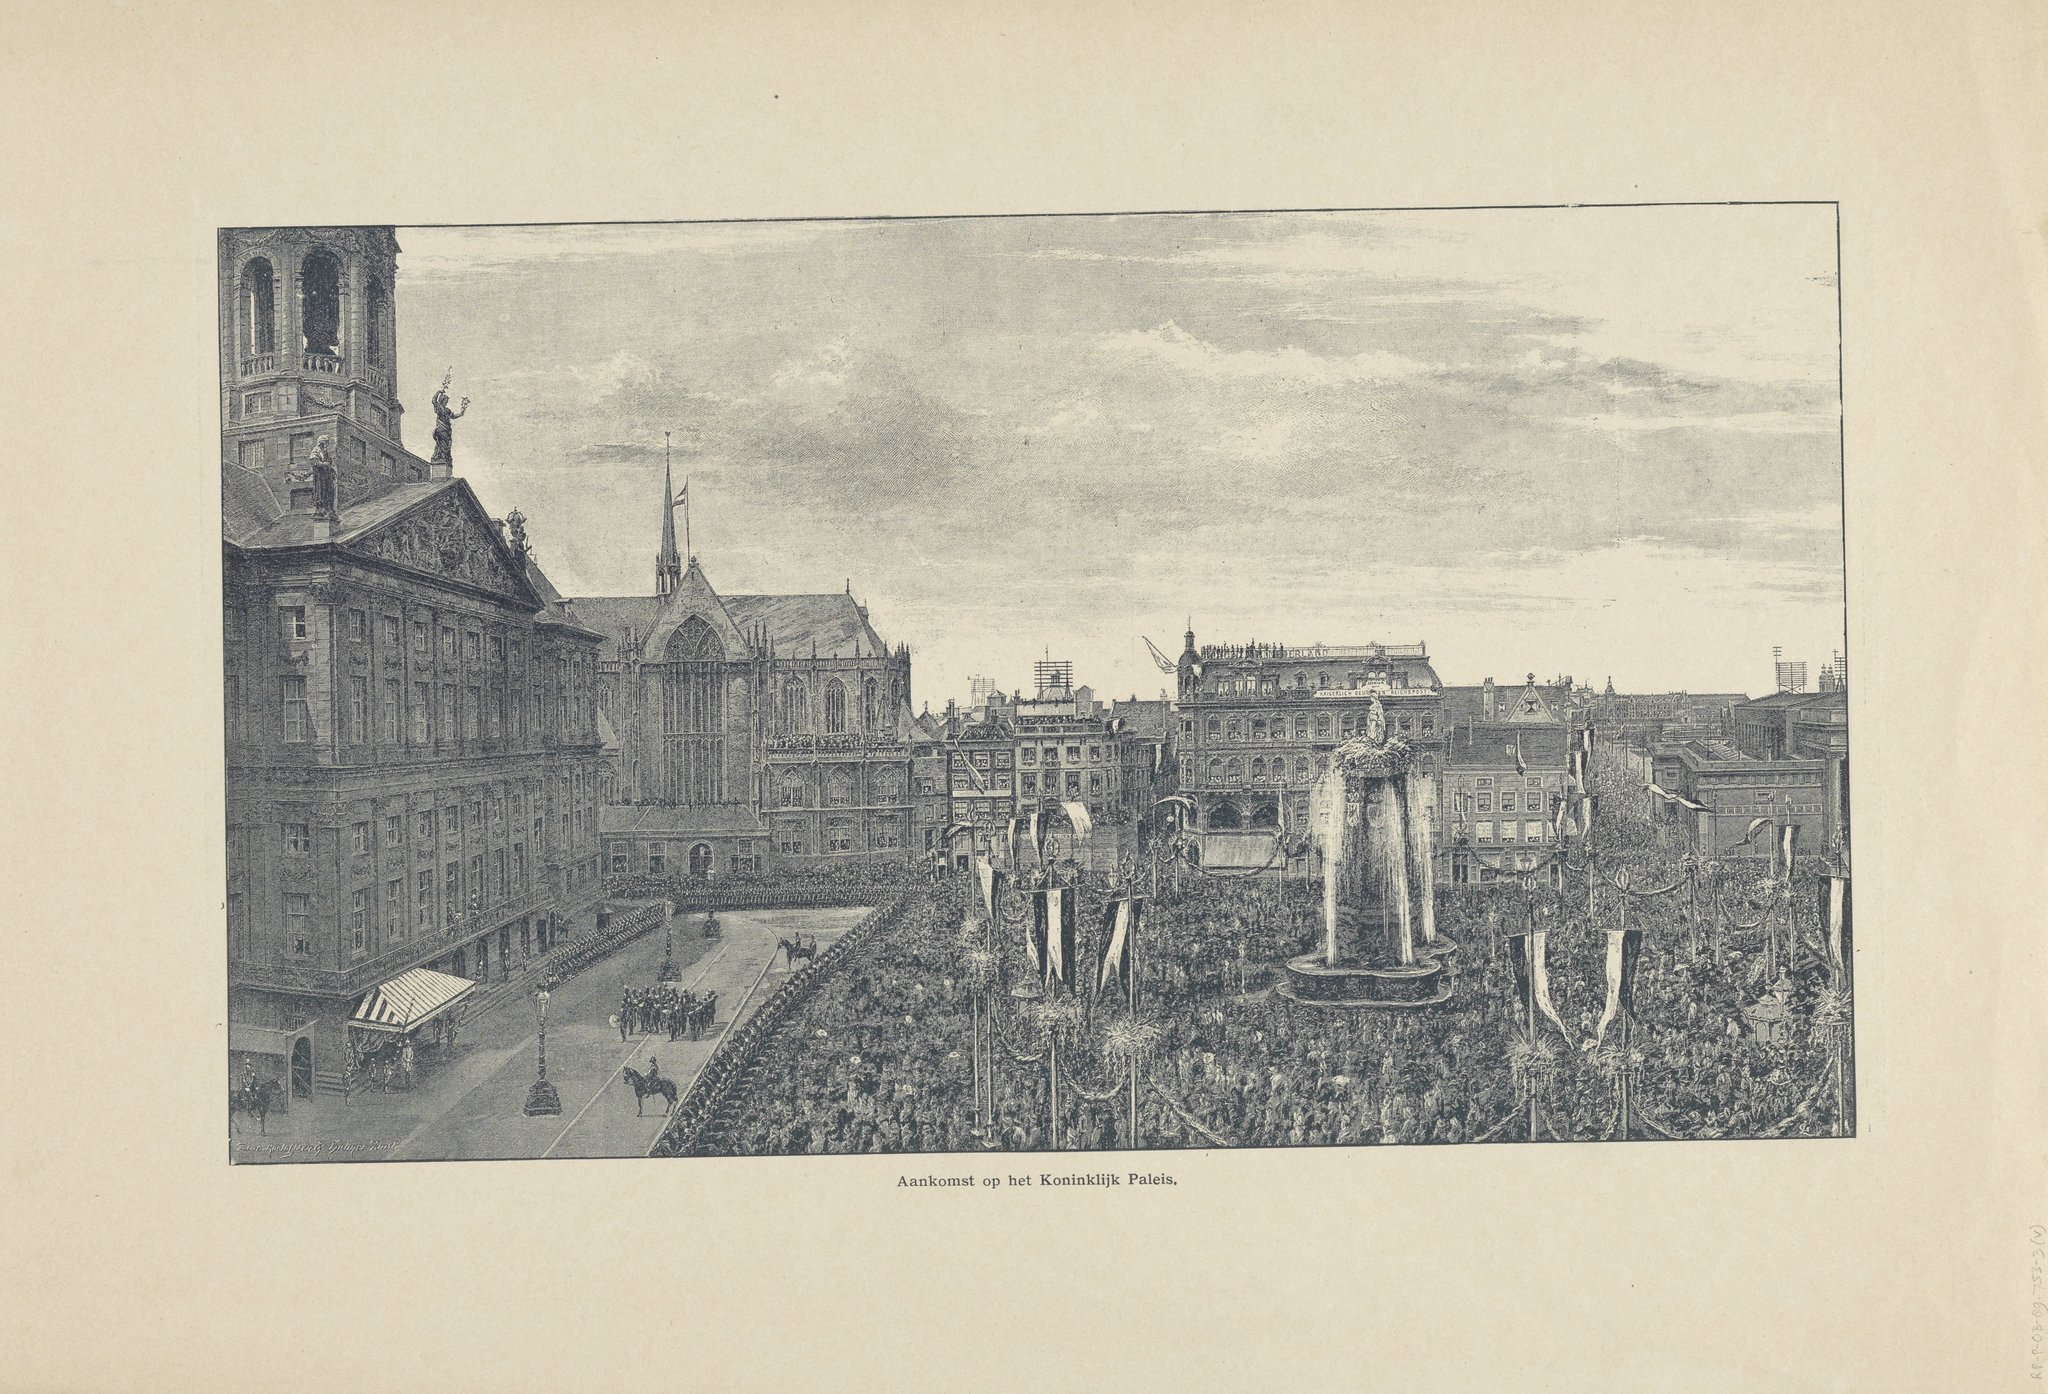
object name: print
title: Aankomst op het Koninklijk Paleis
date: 1807-1891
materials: paper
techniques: lithography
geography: amsterdam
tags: print maker, wilhelmina of the netherlands, the hague, emma (queen consort of the netherlands), wilhelm ii (keizer van duitsland), augusta victoria (keizerin van duitsland), royal palace of amsterdam, amsterdam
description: Aankomst van het gevolg met de Duitse keizer en keizerin bij het Koninklijk Paleis te Amsterdam. Illustratie in het blad bestaande uit vier bladen met tekst en illustraties, uitgegeven ter gelegenheid van het bezoek van de keizer Wilhelm II van Duitsland en de keizerin aan Amsterdam van 1-3 juli 1891.